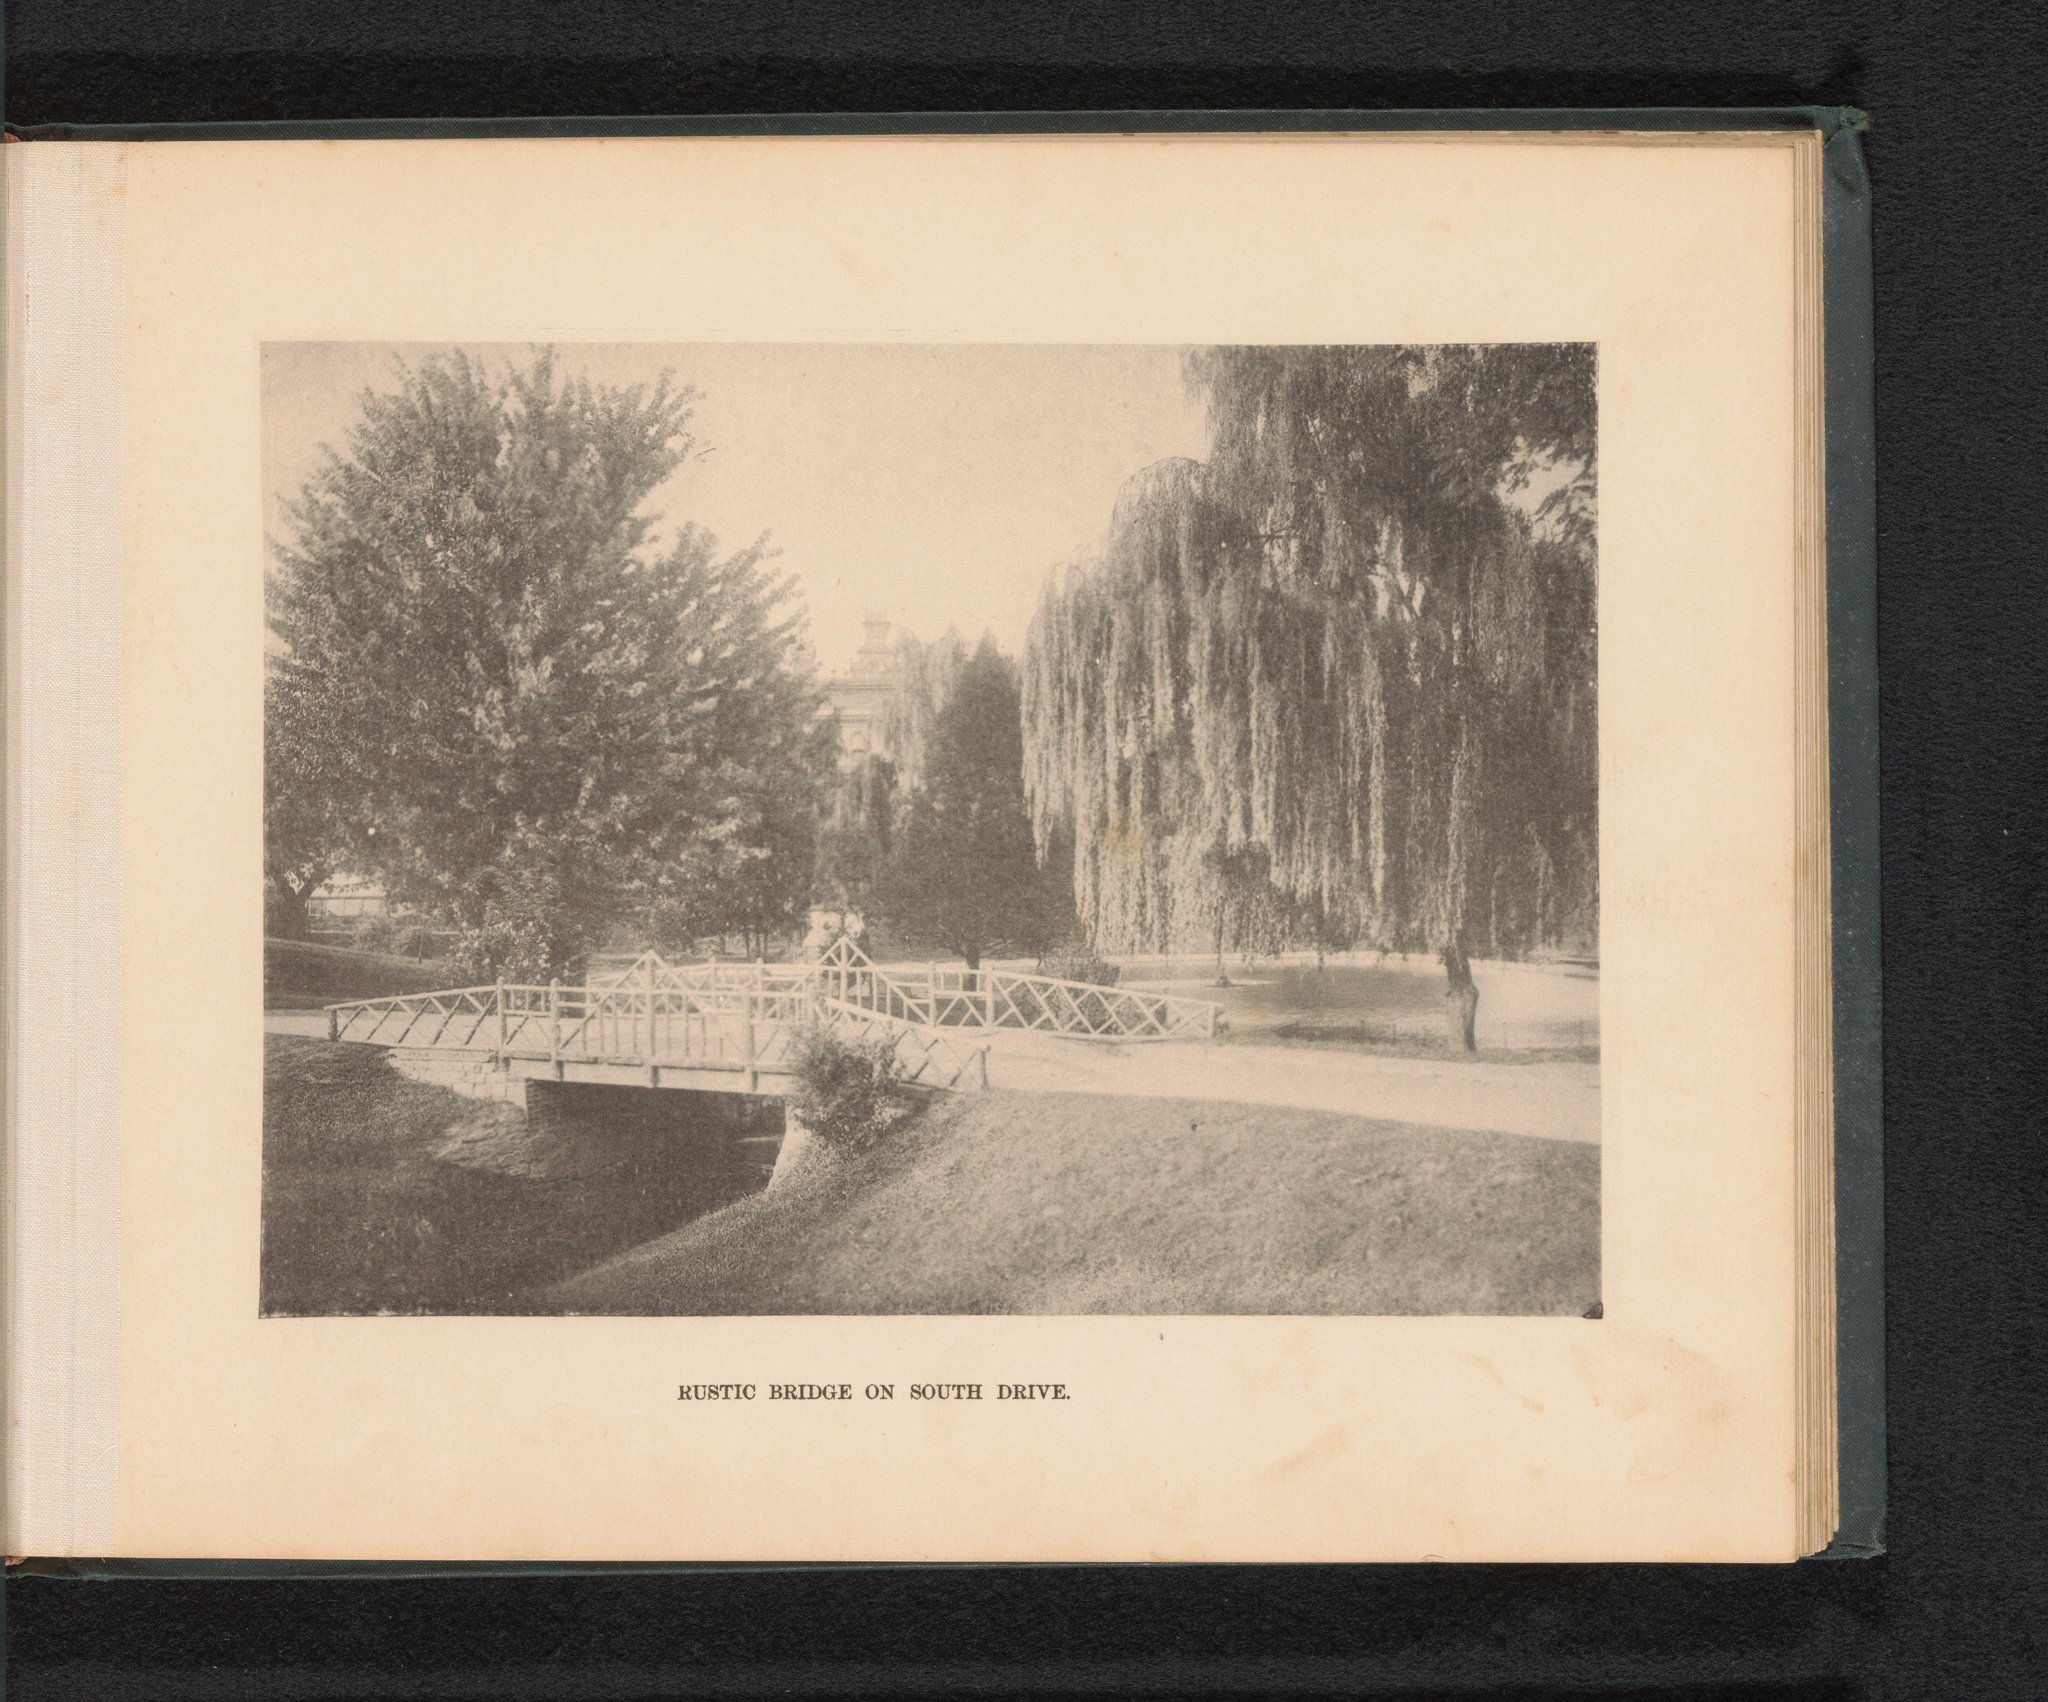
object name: photomechanical print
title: Rustic Bridge on South Drive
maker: Anonymous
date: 1879-1889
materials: paper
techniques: photograph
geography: woodbury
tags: trees, bridge